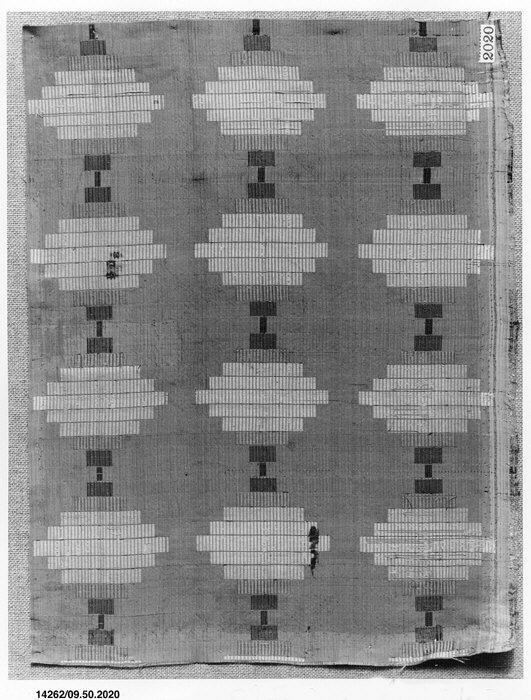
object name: piece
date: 1801-1900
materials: silk